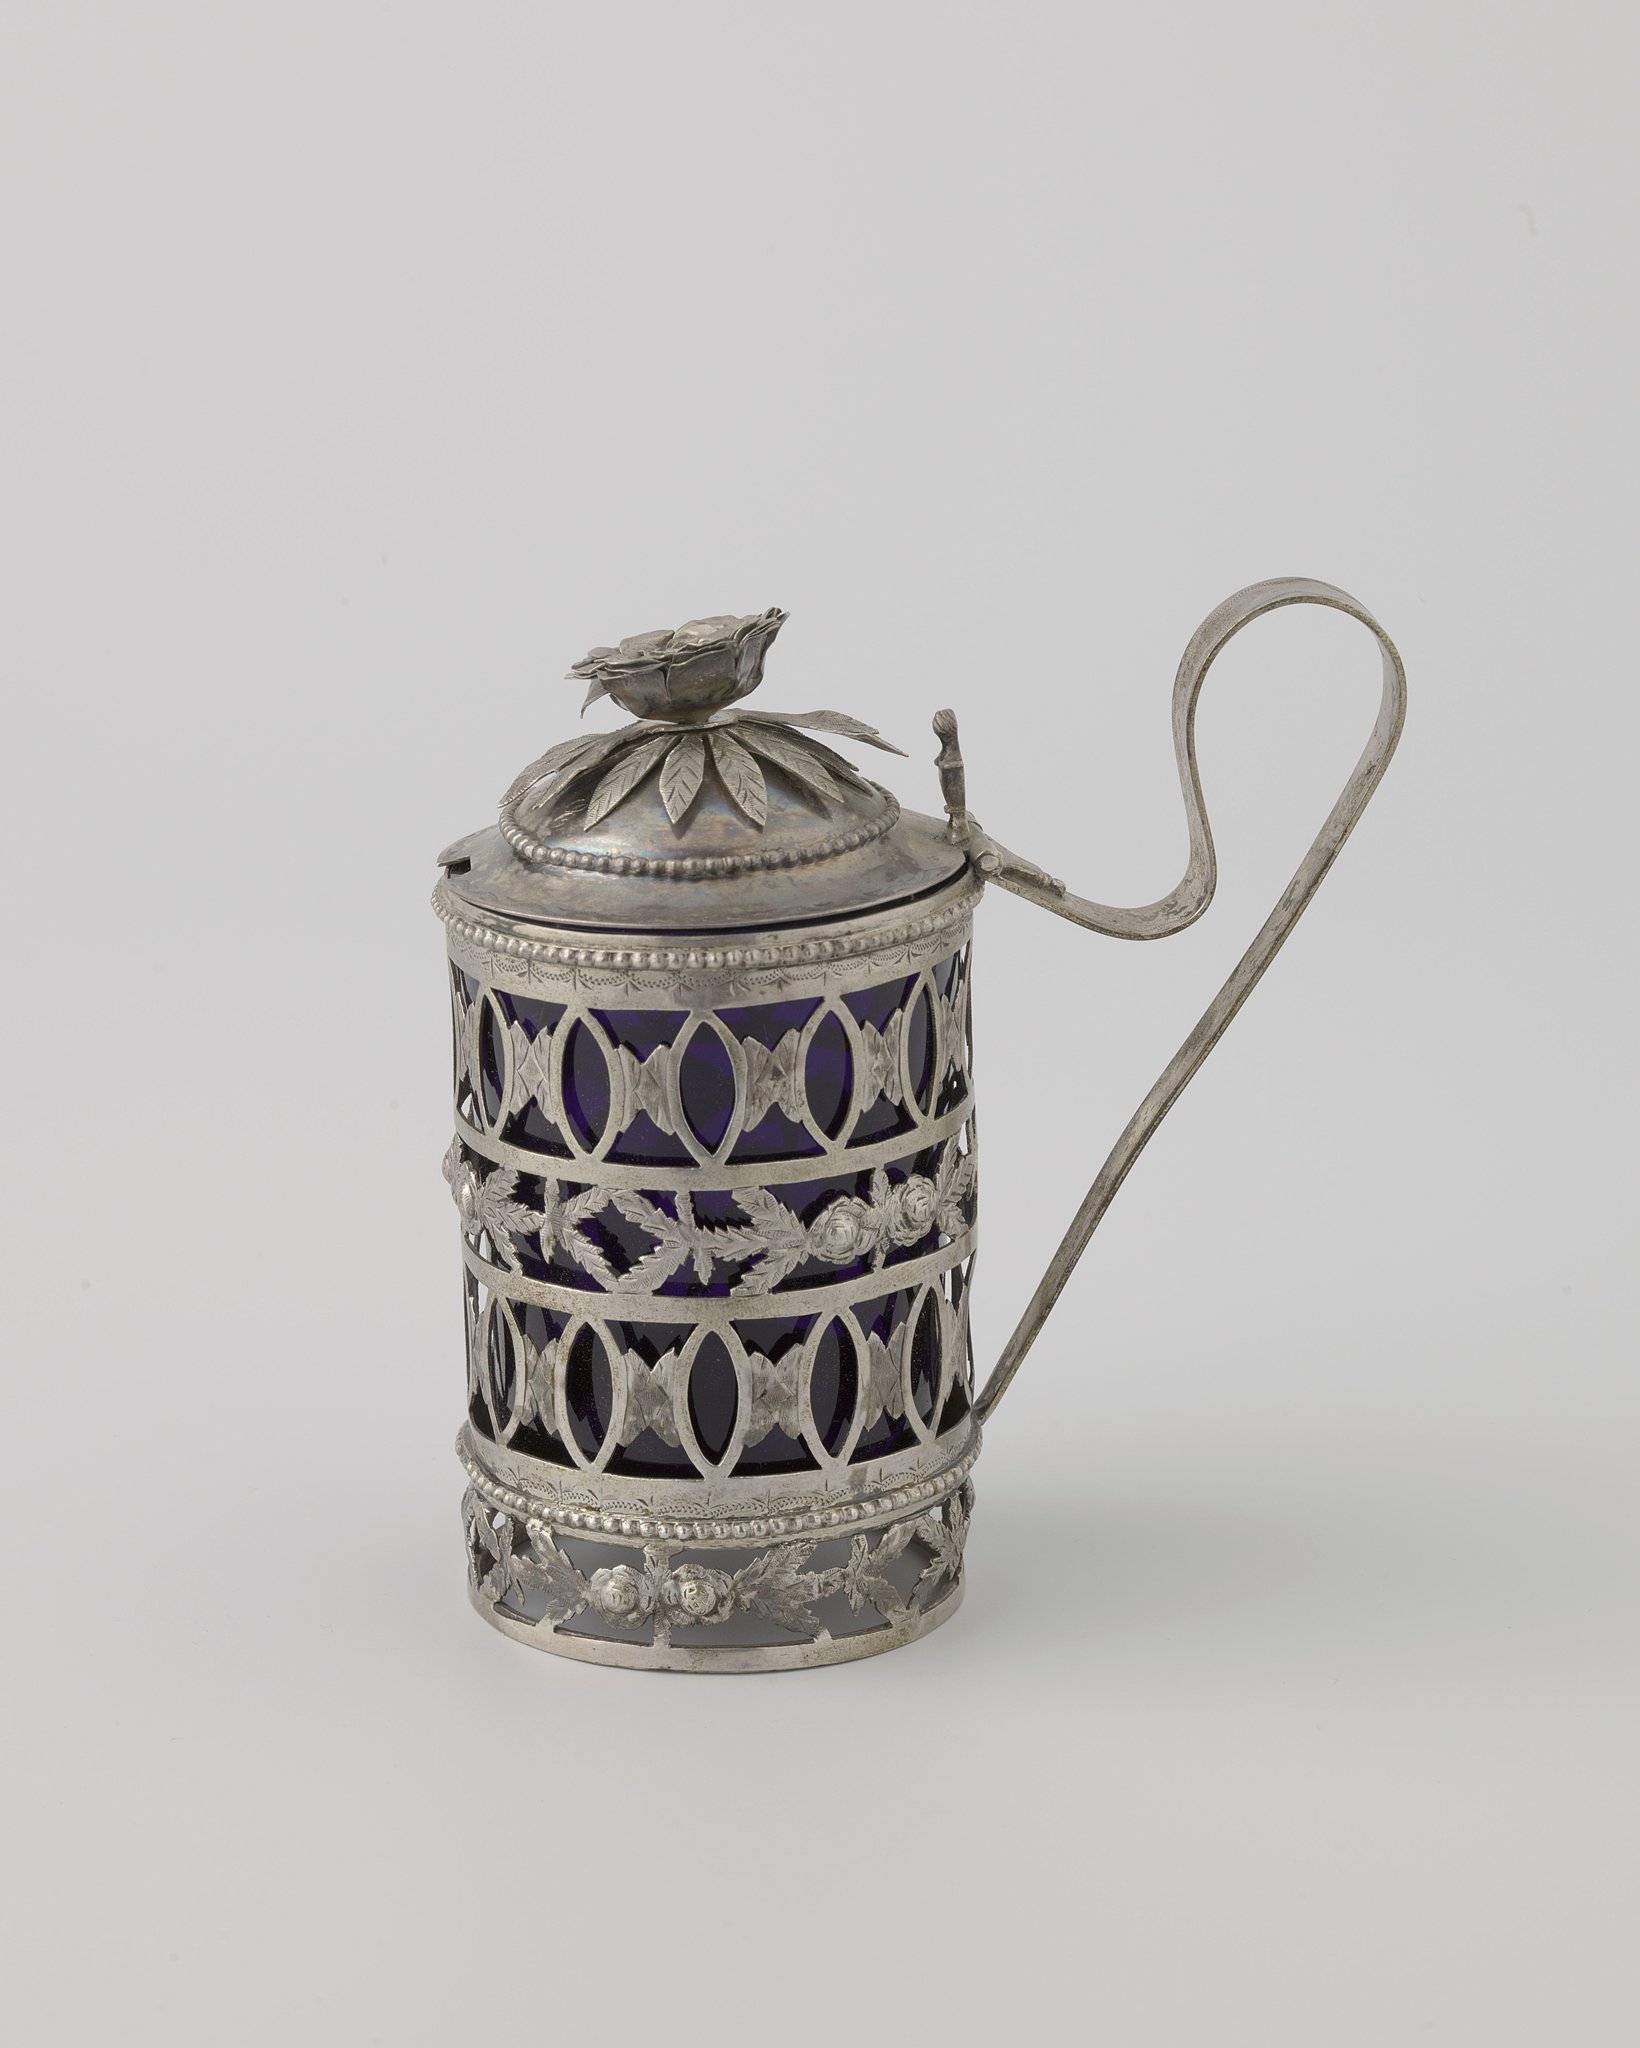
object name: mustard pot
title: Mosterdpot van zilver, rond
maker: Anonymous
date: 1780-1800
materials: silver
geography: utrecht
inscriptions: date letter: ‘U’, town mark: ‘Utrecht’, maker's mark: ‘P.C.S.’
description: Mosterdpot van zilver met deksel. Cilindrisch met opengewerkte rand in vier boven elkaar gestelde randen waarin afwisselend geciseleerde toegewende bloem- en bladmotieven, en spits ovalen, verbondenmet geciseleerde plaques. Deksel gewelfd, halverwege een parelrand. Initialen L.P. gegraveerd. Knop als bloem met daaronder een vrijstaande bladrozet. Oor lusvormig opgetrokken.